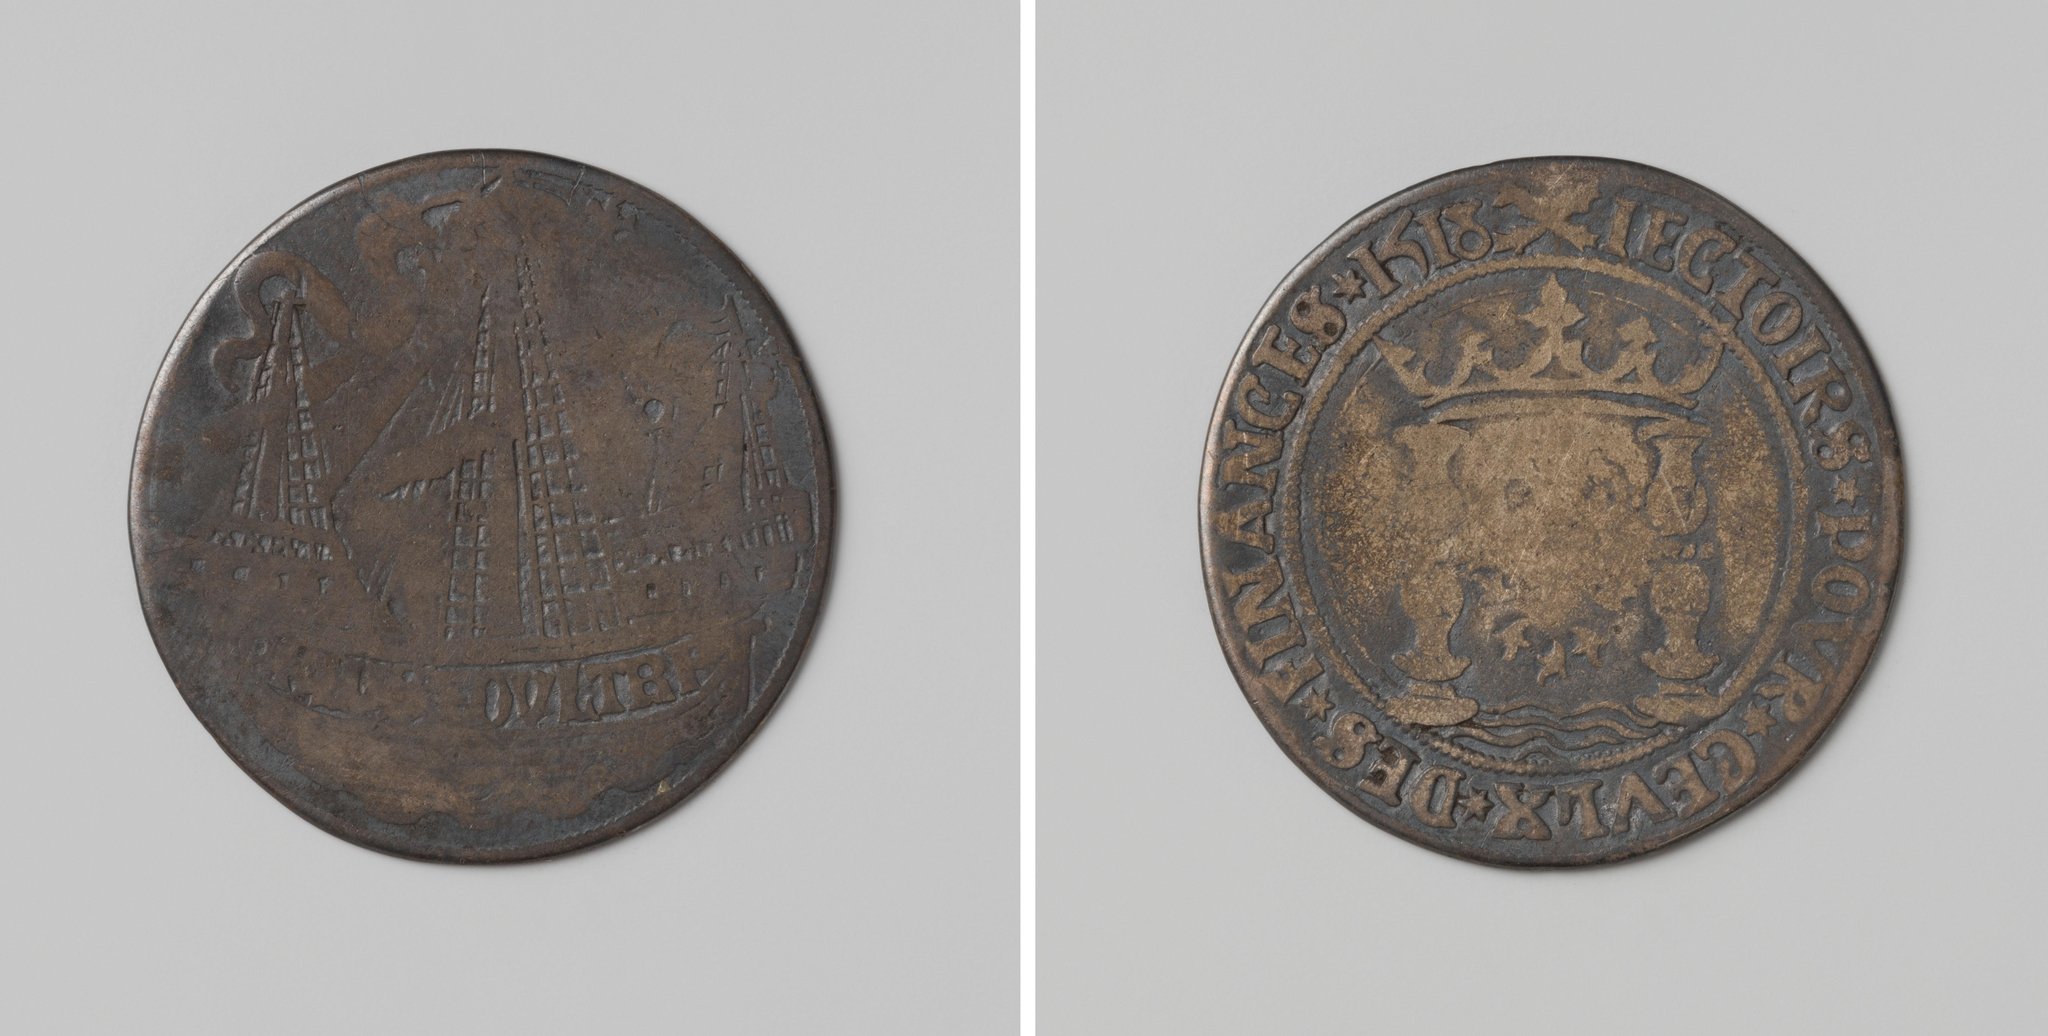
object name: jeton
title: Landing van Karel I bij Tazones in Spanje, rekenpenning van de raad van Financiën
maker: Anonymous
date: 1518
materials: silver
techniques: striking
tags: ghent, charles v (holy roman emperor and king of spain)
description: Zilveren penning. Voorzijde: zeilende driemaster; op boord: opschrift. Keerzijde: vuurslag, steen en vonken tussen zuilen van Herkules onder kroon binnen omschrift